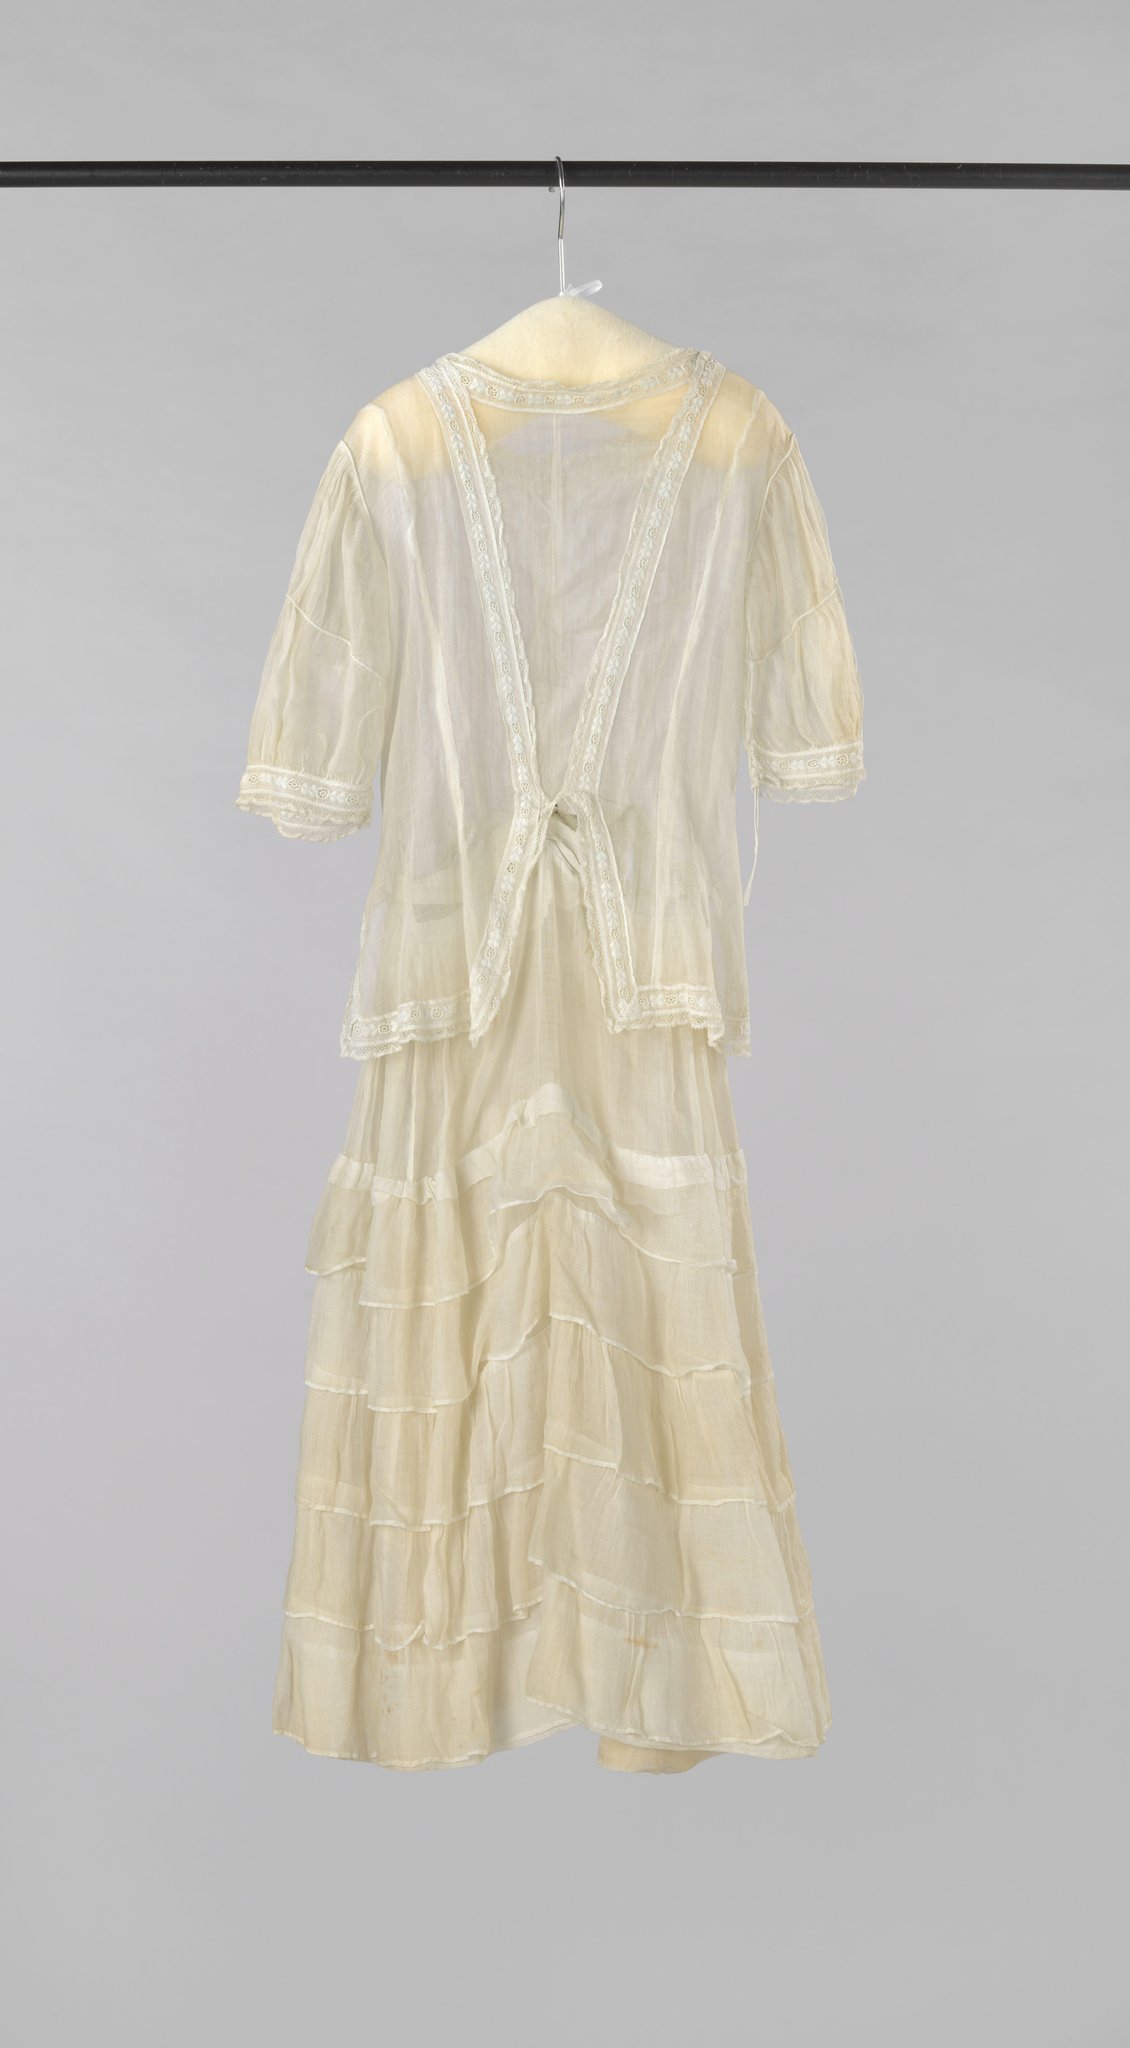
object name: main garment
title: Lijf van een kinderjurk met achtersluiting met 7 stofknopen en van onderen met een voorsplit, twee zij- en twee achtersplitten, van neteldoek met Engels borduurwerk en kant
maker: Anonymous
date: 1875-1880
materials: textile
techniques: embroidered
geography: netherlands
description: Lijf van een kinderjurk met achtersluiting met 7 stofknopen en van onderen met een voorsplit, twee zij- en twee achtersplitten, van neteldoek met Engels borduurwerk en kant.